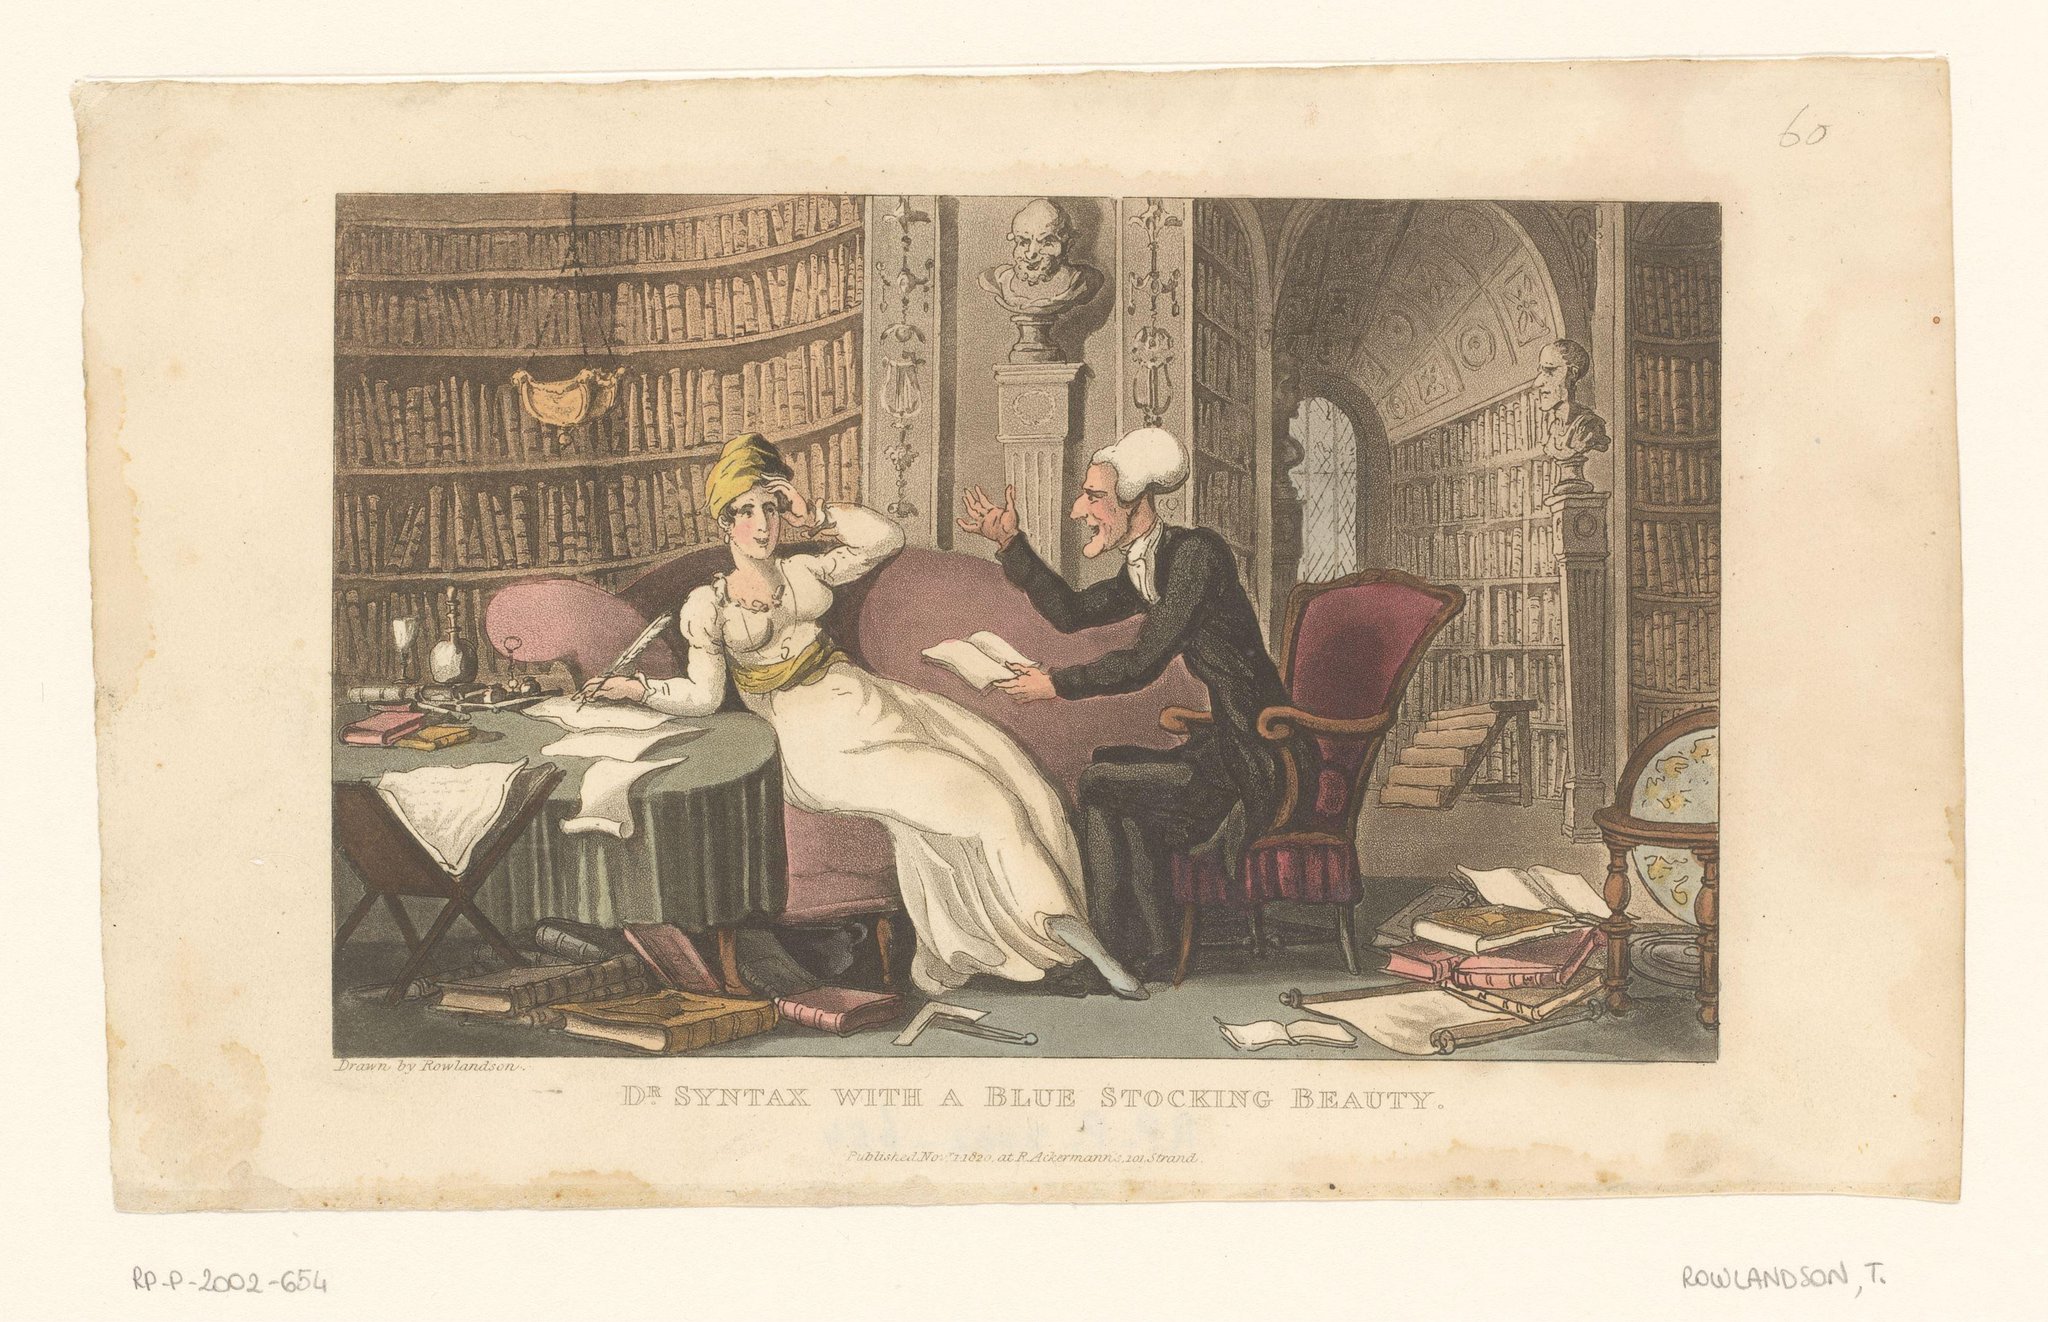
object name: cartoon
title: Doctor Syntax met een vrouw in een bibliotheek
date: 1811-1820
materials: paper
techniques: aquatint, etching, hand coloring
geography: london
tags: writing-table, writing-desk, study; 'studiolo'; library, reading to somebody, globe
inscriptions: collector's mark: Lugt 2228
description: In een bibliotheek zit een vrouw op een sofa naast een schrijftafel. Op een stoel naast haar zit Doctor Syntax; waarschijnlijk leest hij voor uit een boek. Op de voorgrond liggen boeken en andere objecten en rechts staat een globe.